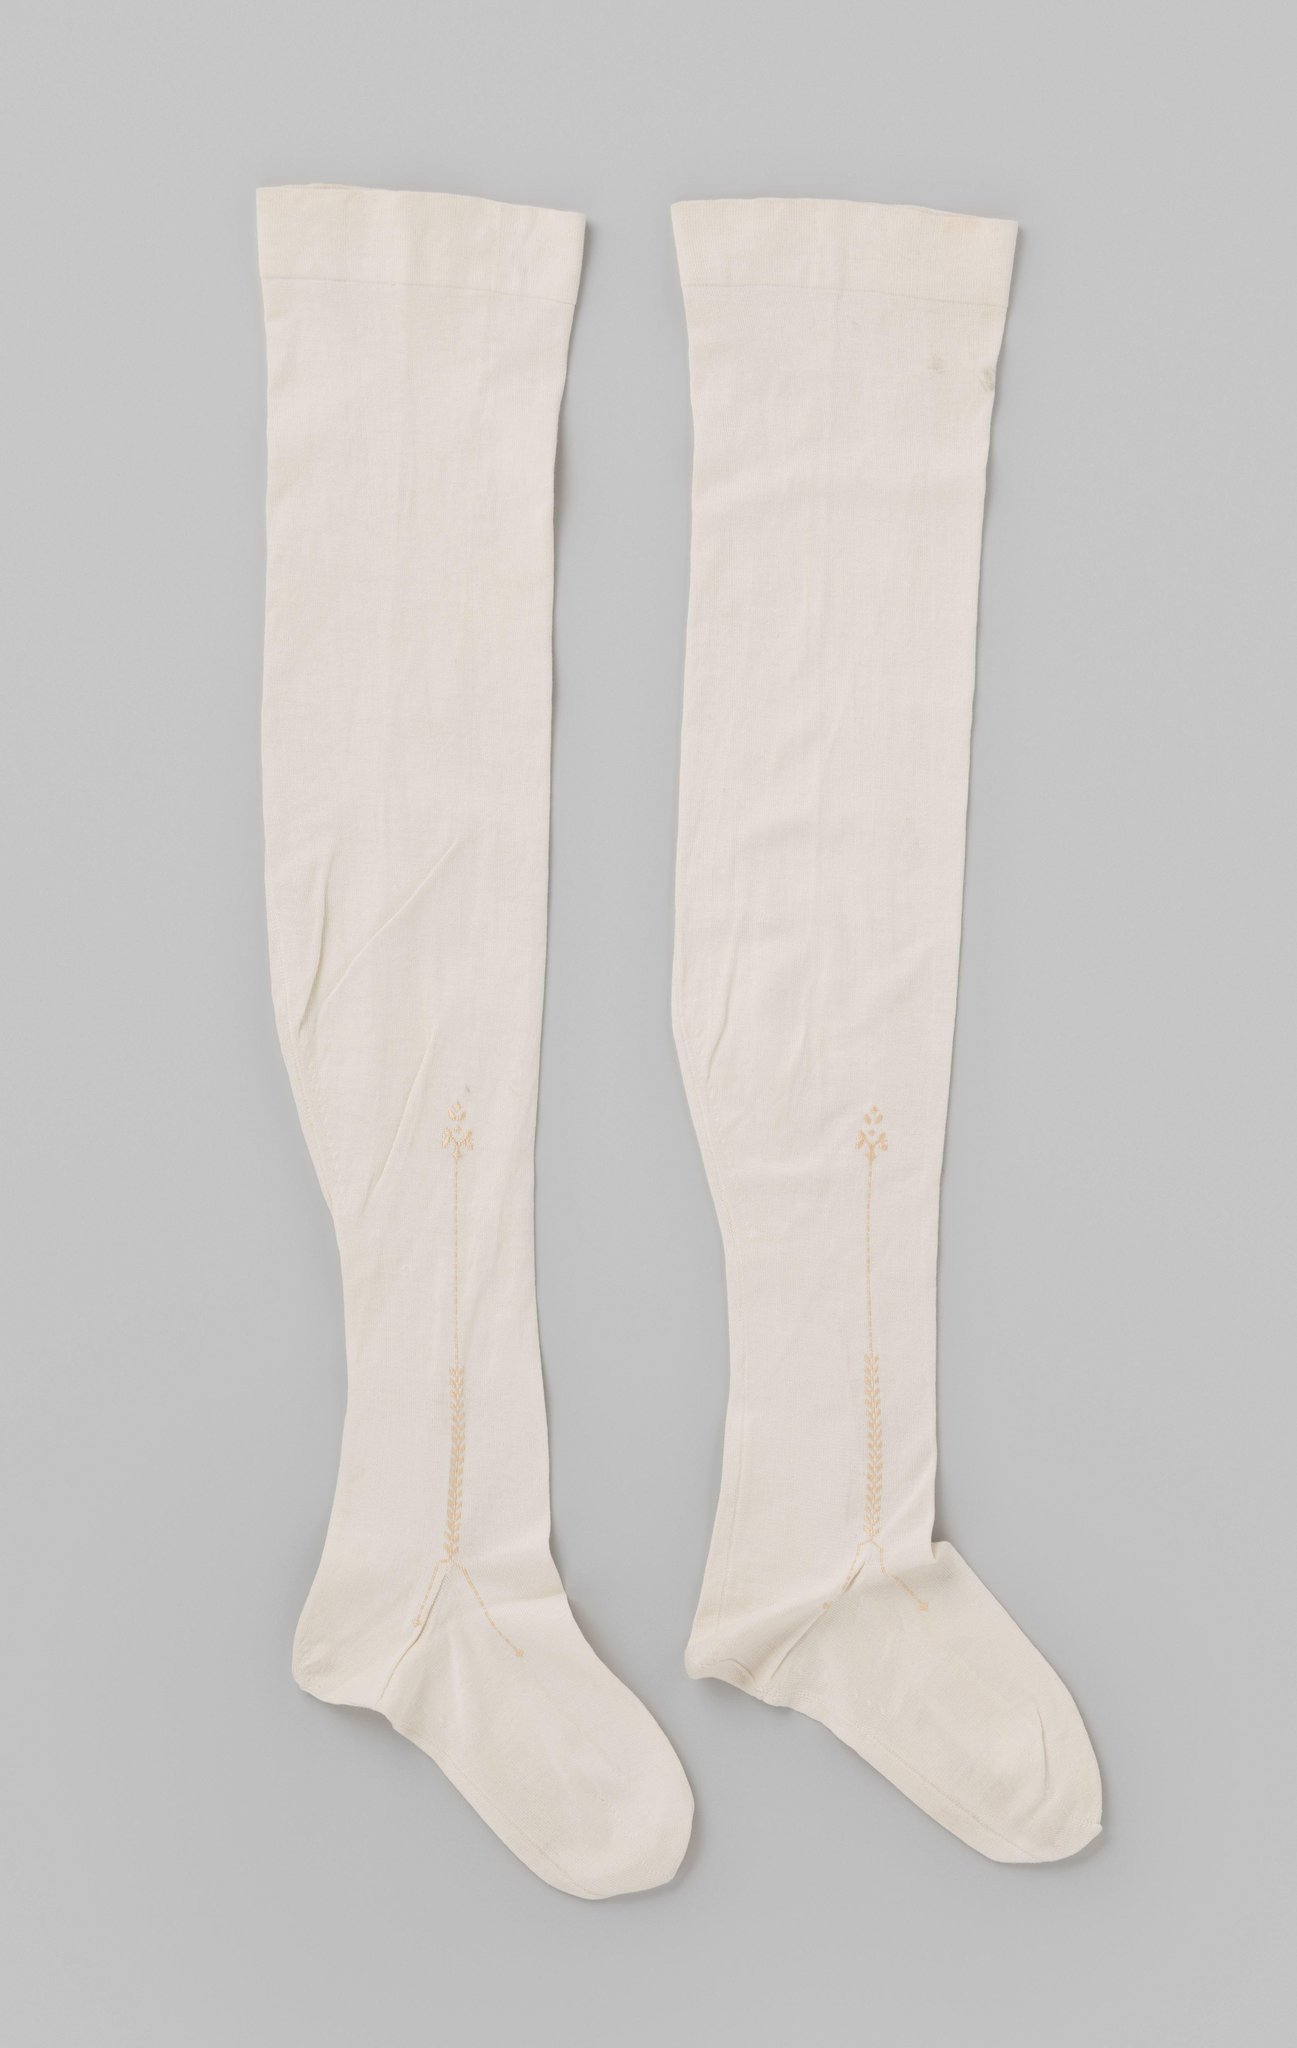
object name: stocking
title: Kous van effen witte katoenen tricot met op de klink een geborduurde sierpijl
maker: Anonymous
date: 1830-1835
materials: cotton, silk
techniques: cross stitching, embroidered, knitting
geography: netherlands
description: Kous van effen witte katoenen tricot met op de klink een in zijde geborduurde sierpijl. Op de boord in rode kruissteek: '3'.